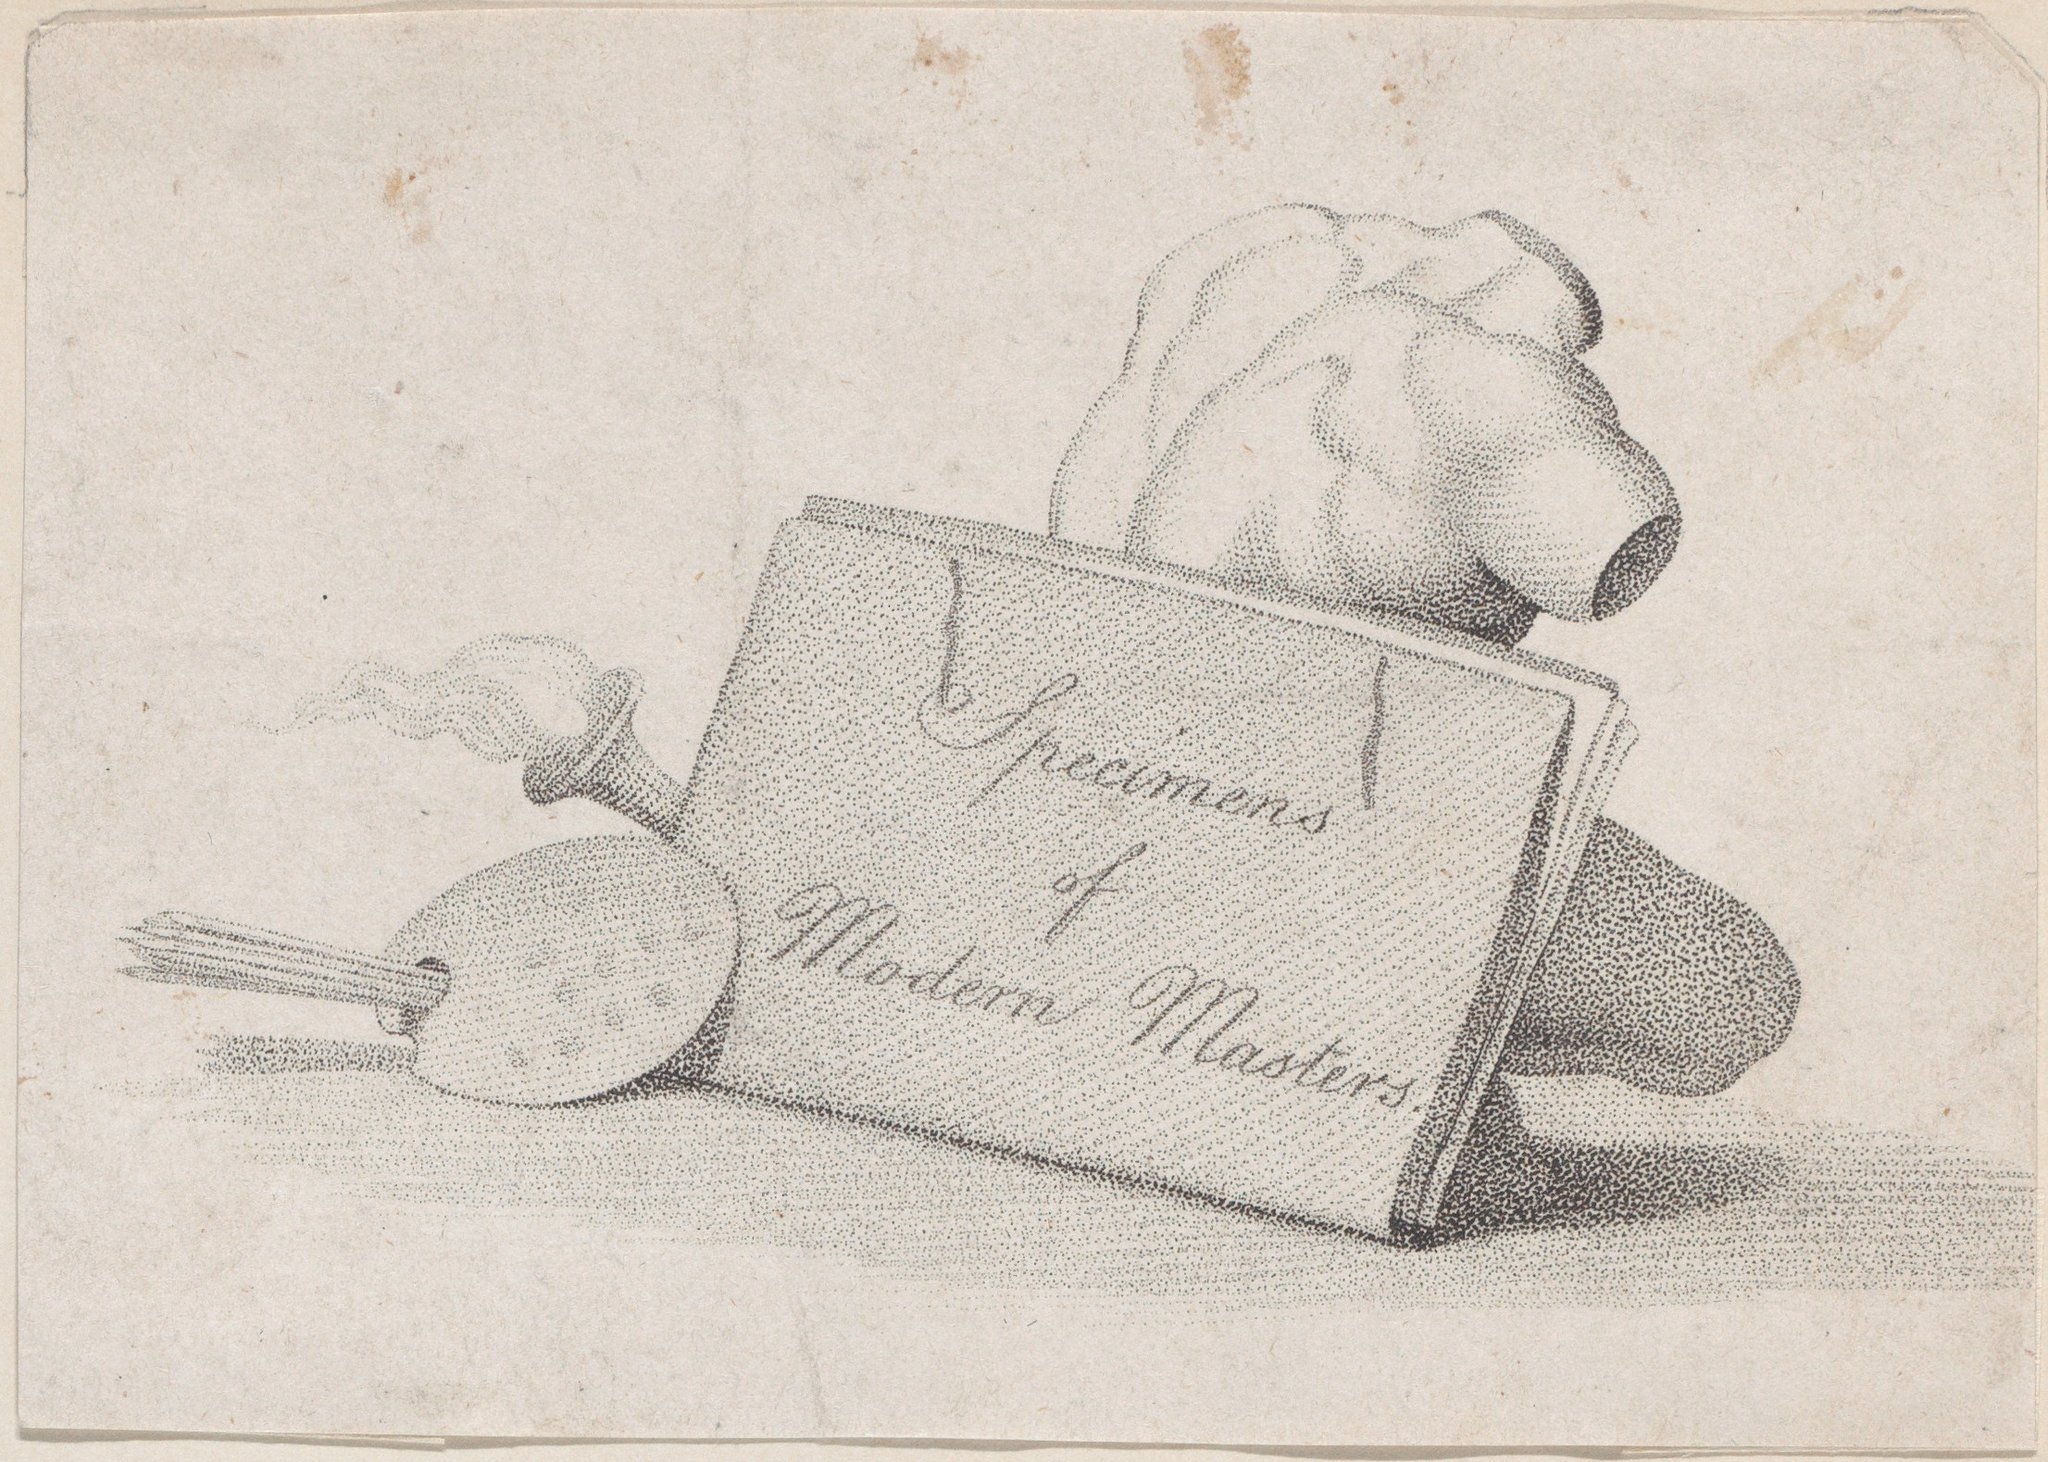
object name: print, trade card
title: Specimens of Modern Masters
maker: anonymous, british, 18th century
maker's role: artist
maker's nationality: british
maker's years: 1700-1800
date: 1701-1800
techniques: etching